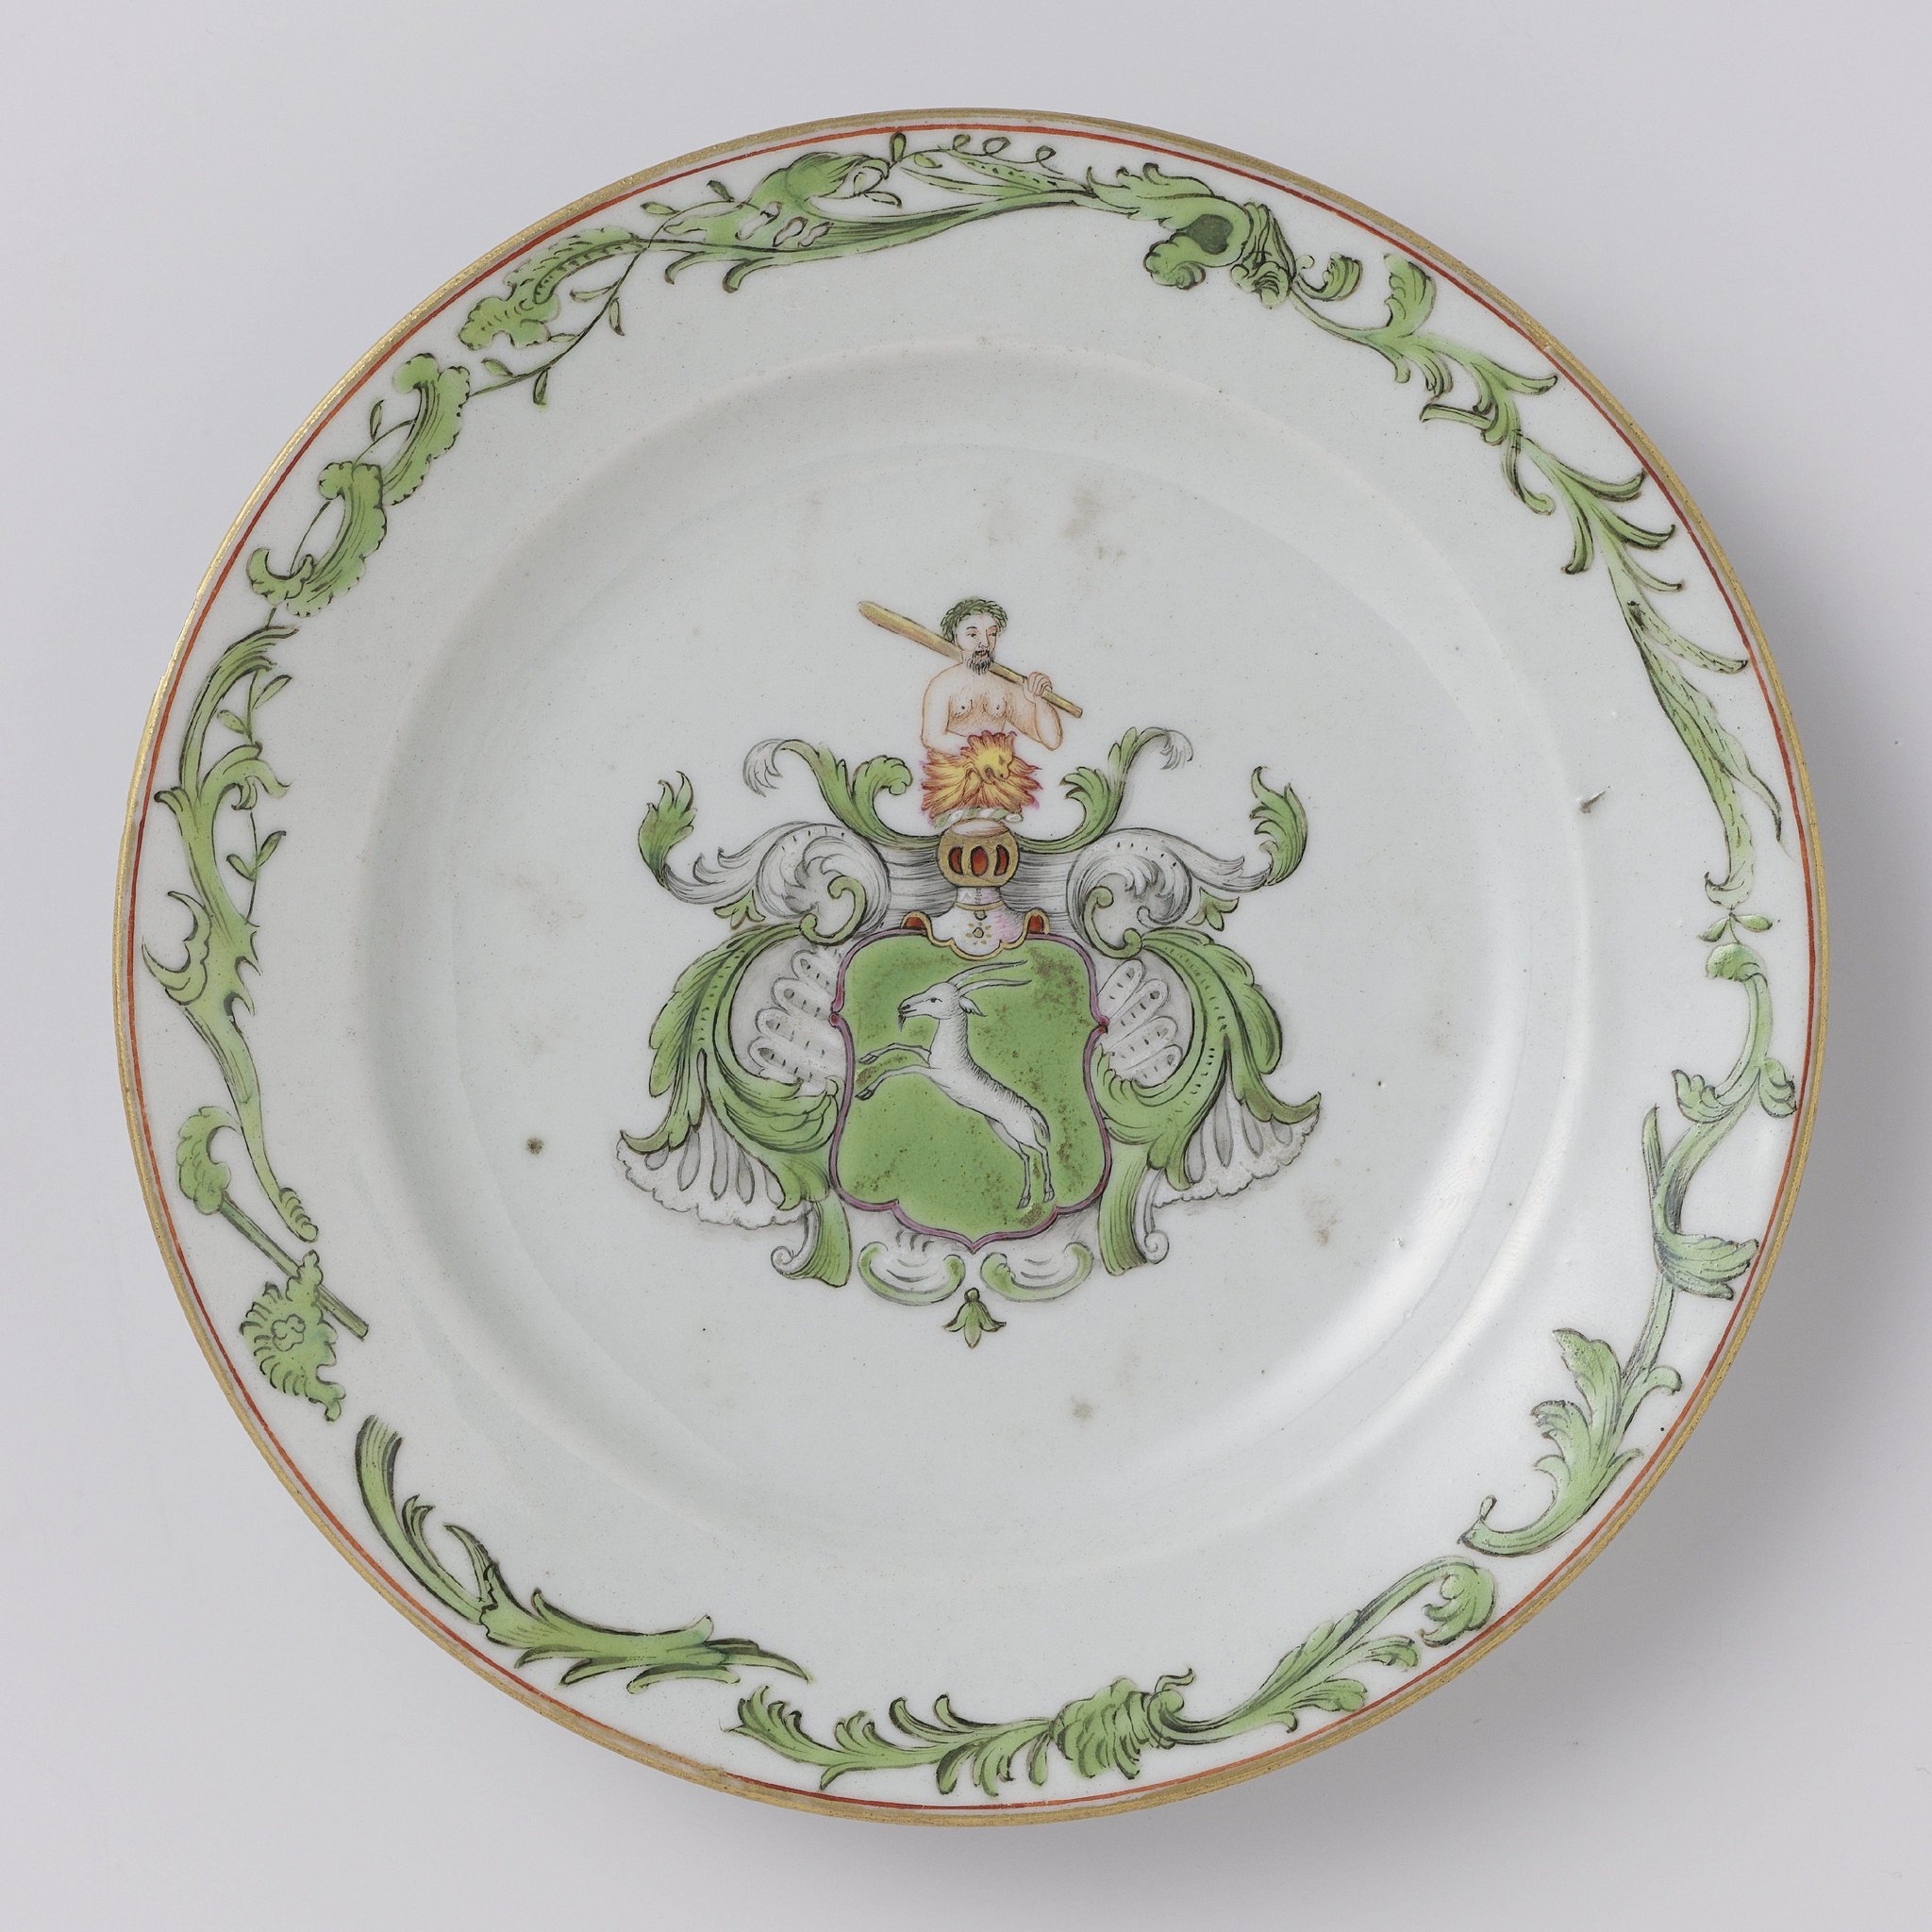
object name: plate dish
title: Plate with the arms of the De Wilde family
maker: Anonymous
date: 1740-1760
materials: glaze, gold, paint, porcelain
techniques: firing, gilding, turning, vitrification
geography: china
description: Bord van porselein, beschilderd op het glazuur in rood, roze, groen, geel, zwart en goud. Op het plat het wapen van de familie De Wilde (een springende geit). Het helmteken is een leeuwenhoofd met manen met daarboven een wilde man of barbaar die een knots vasthoudt. Het dekkleed bestaat uit bladranken in Europese stijl. Op de rand een loofwerk van bladranken en palmtakken in rococo-stijl. Wapenporselein met emailkleuren.